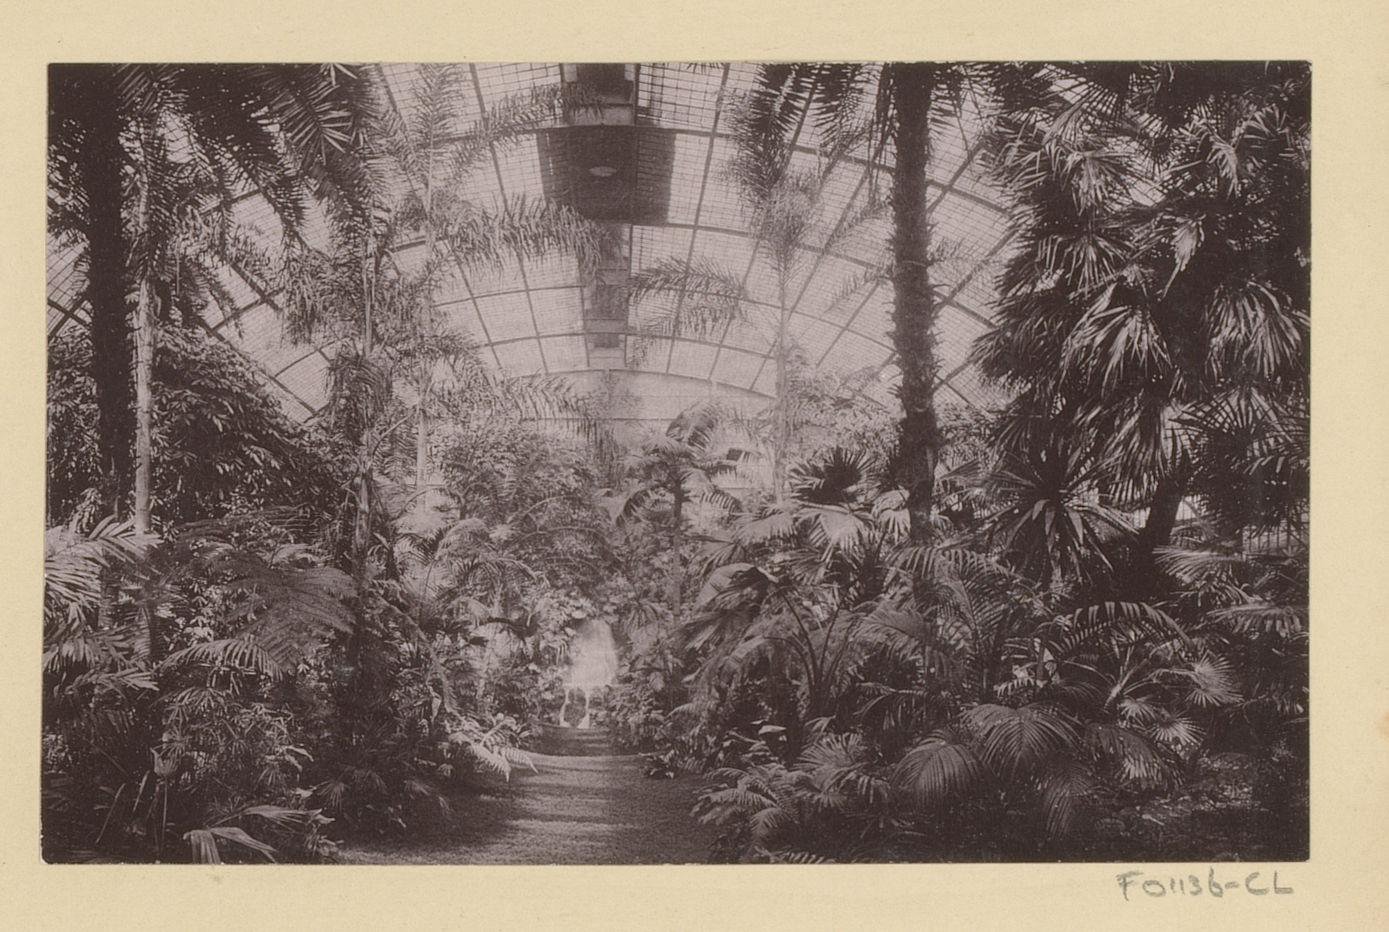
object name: photomechanical print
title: Interieur van een kas in de Palmentuin van Frankfurt am Main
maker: Anonymous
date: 1880-1895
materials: paper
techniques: photograph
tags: trees: palm-tree, botanic garden, 'hortus botanicus', greenhouse, orangery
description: Onderdeel van Fotoalbum met opnames van bezienswaardigheden in België, Duitsland en Noorwegen.